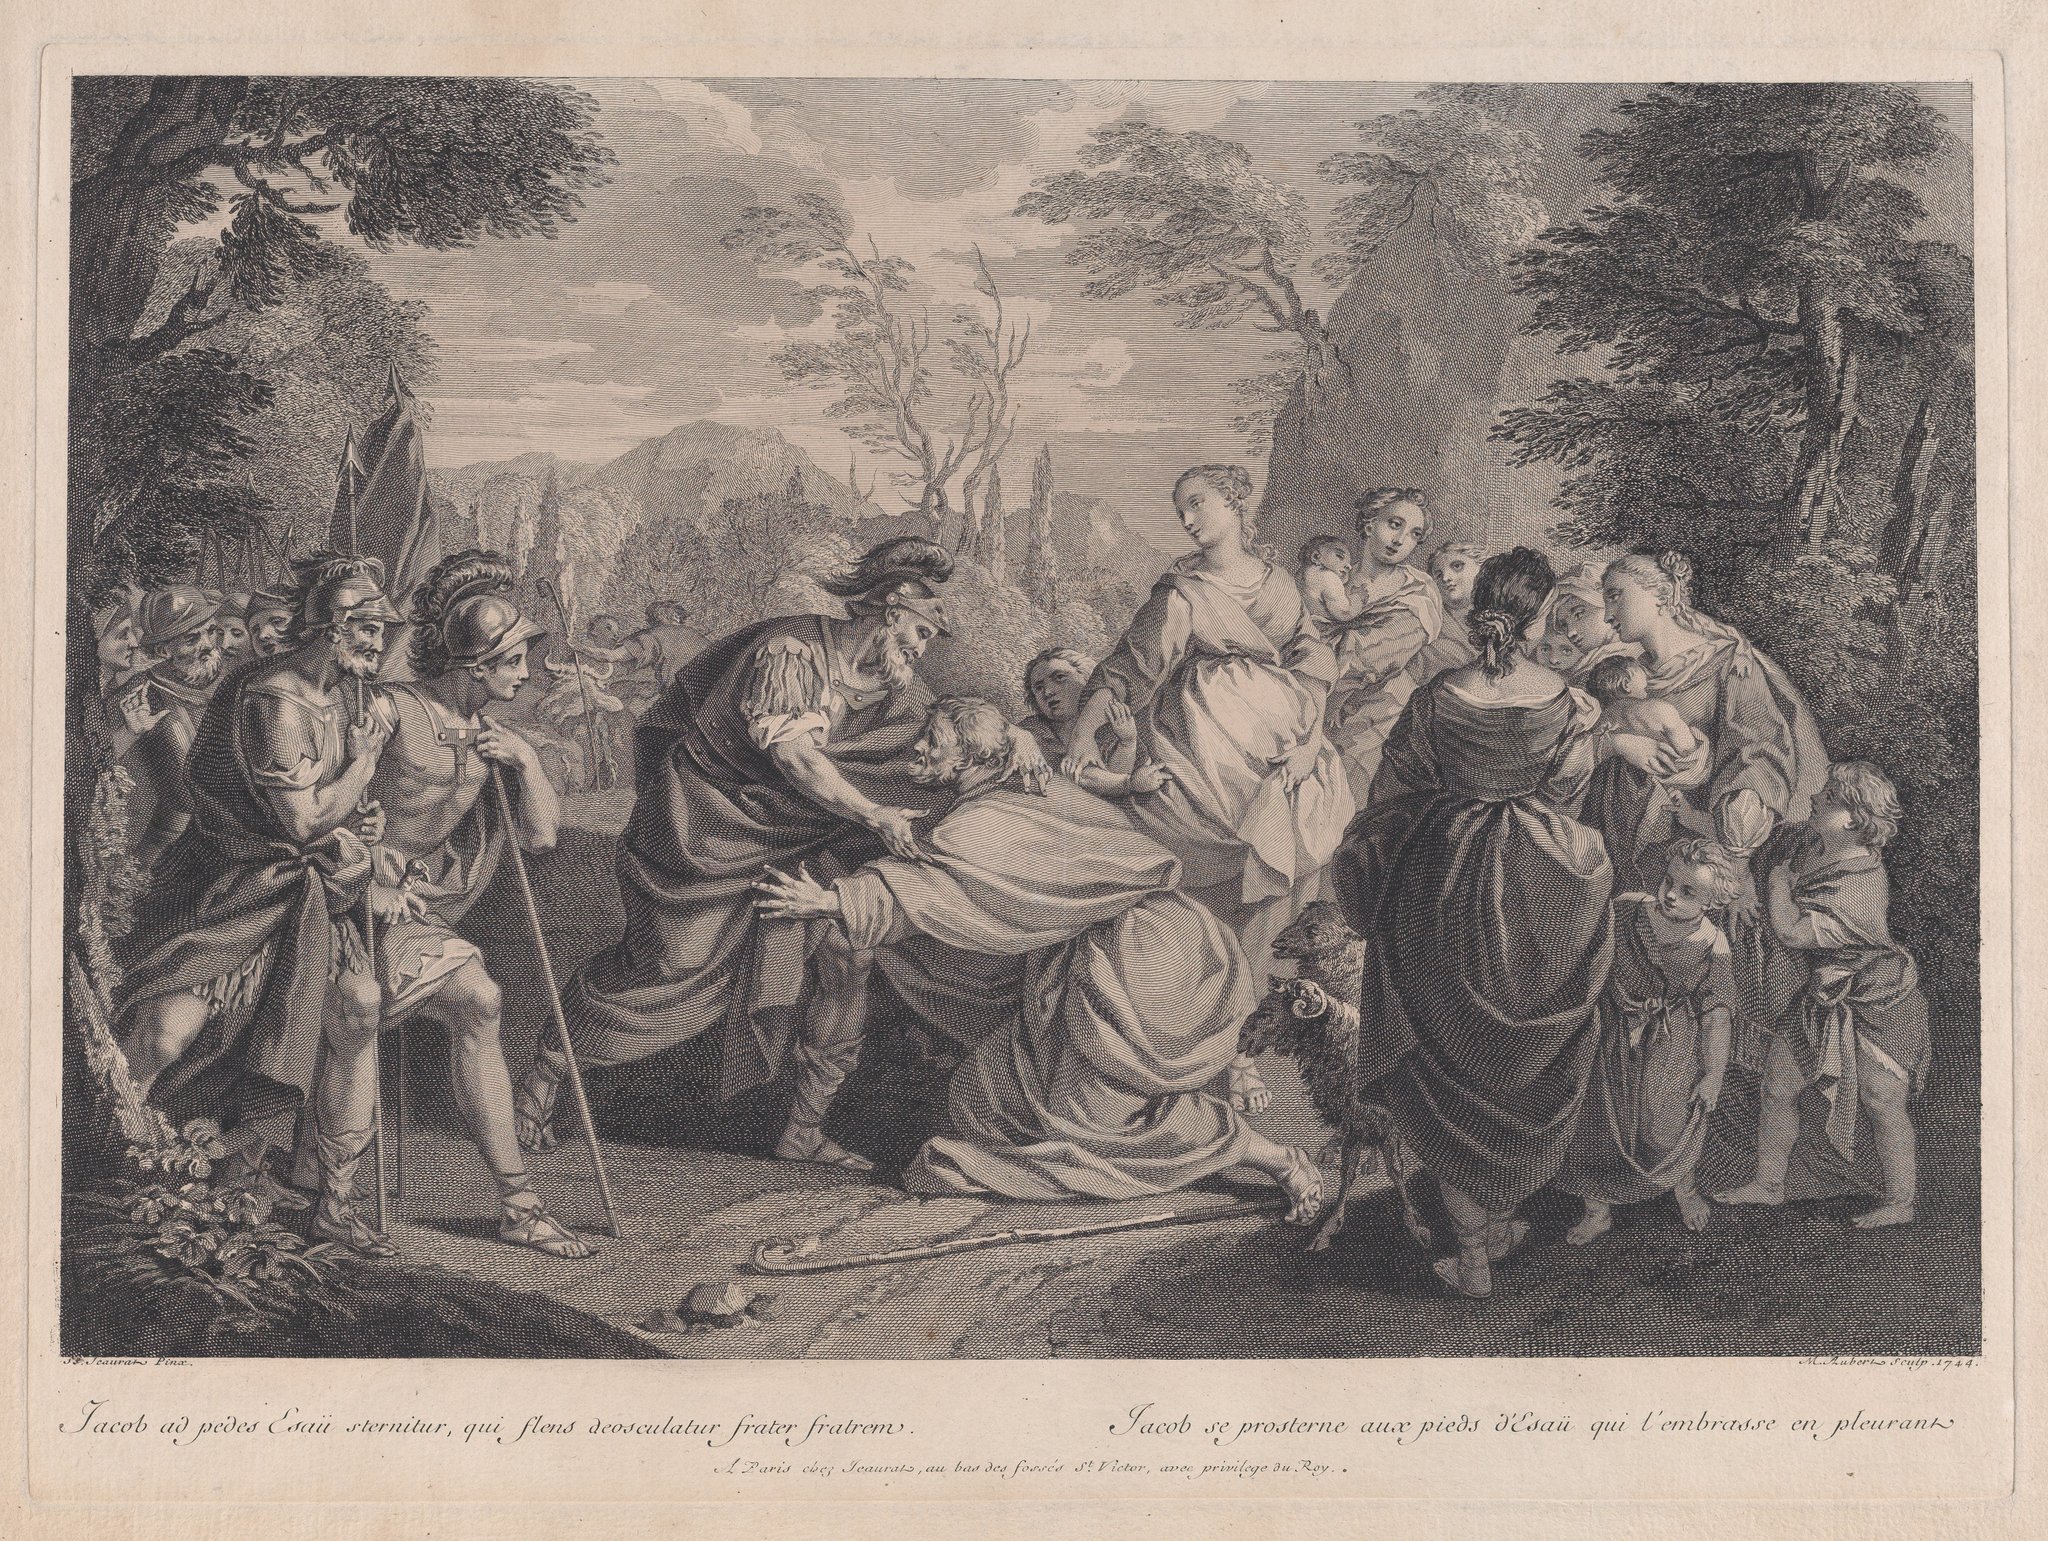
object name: print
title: Jacob and Esau, after Etienne Jeaurat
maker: michel aubert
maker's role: artist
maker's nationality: french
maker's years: 1700-1757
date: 1744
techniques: etching